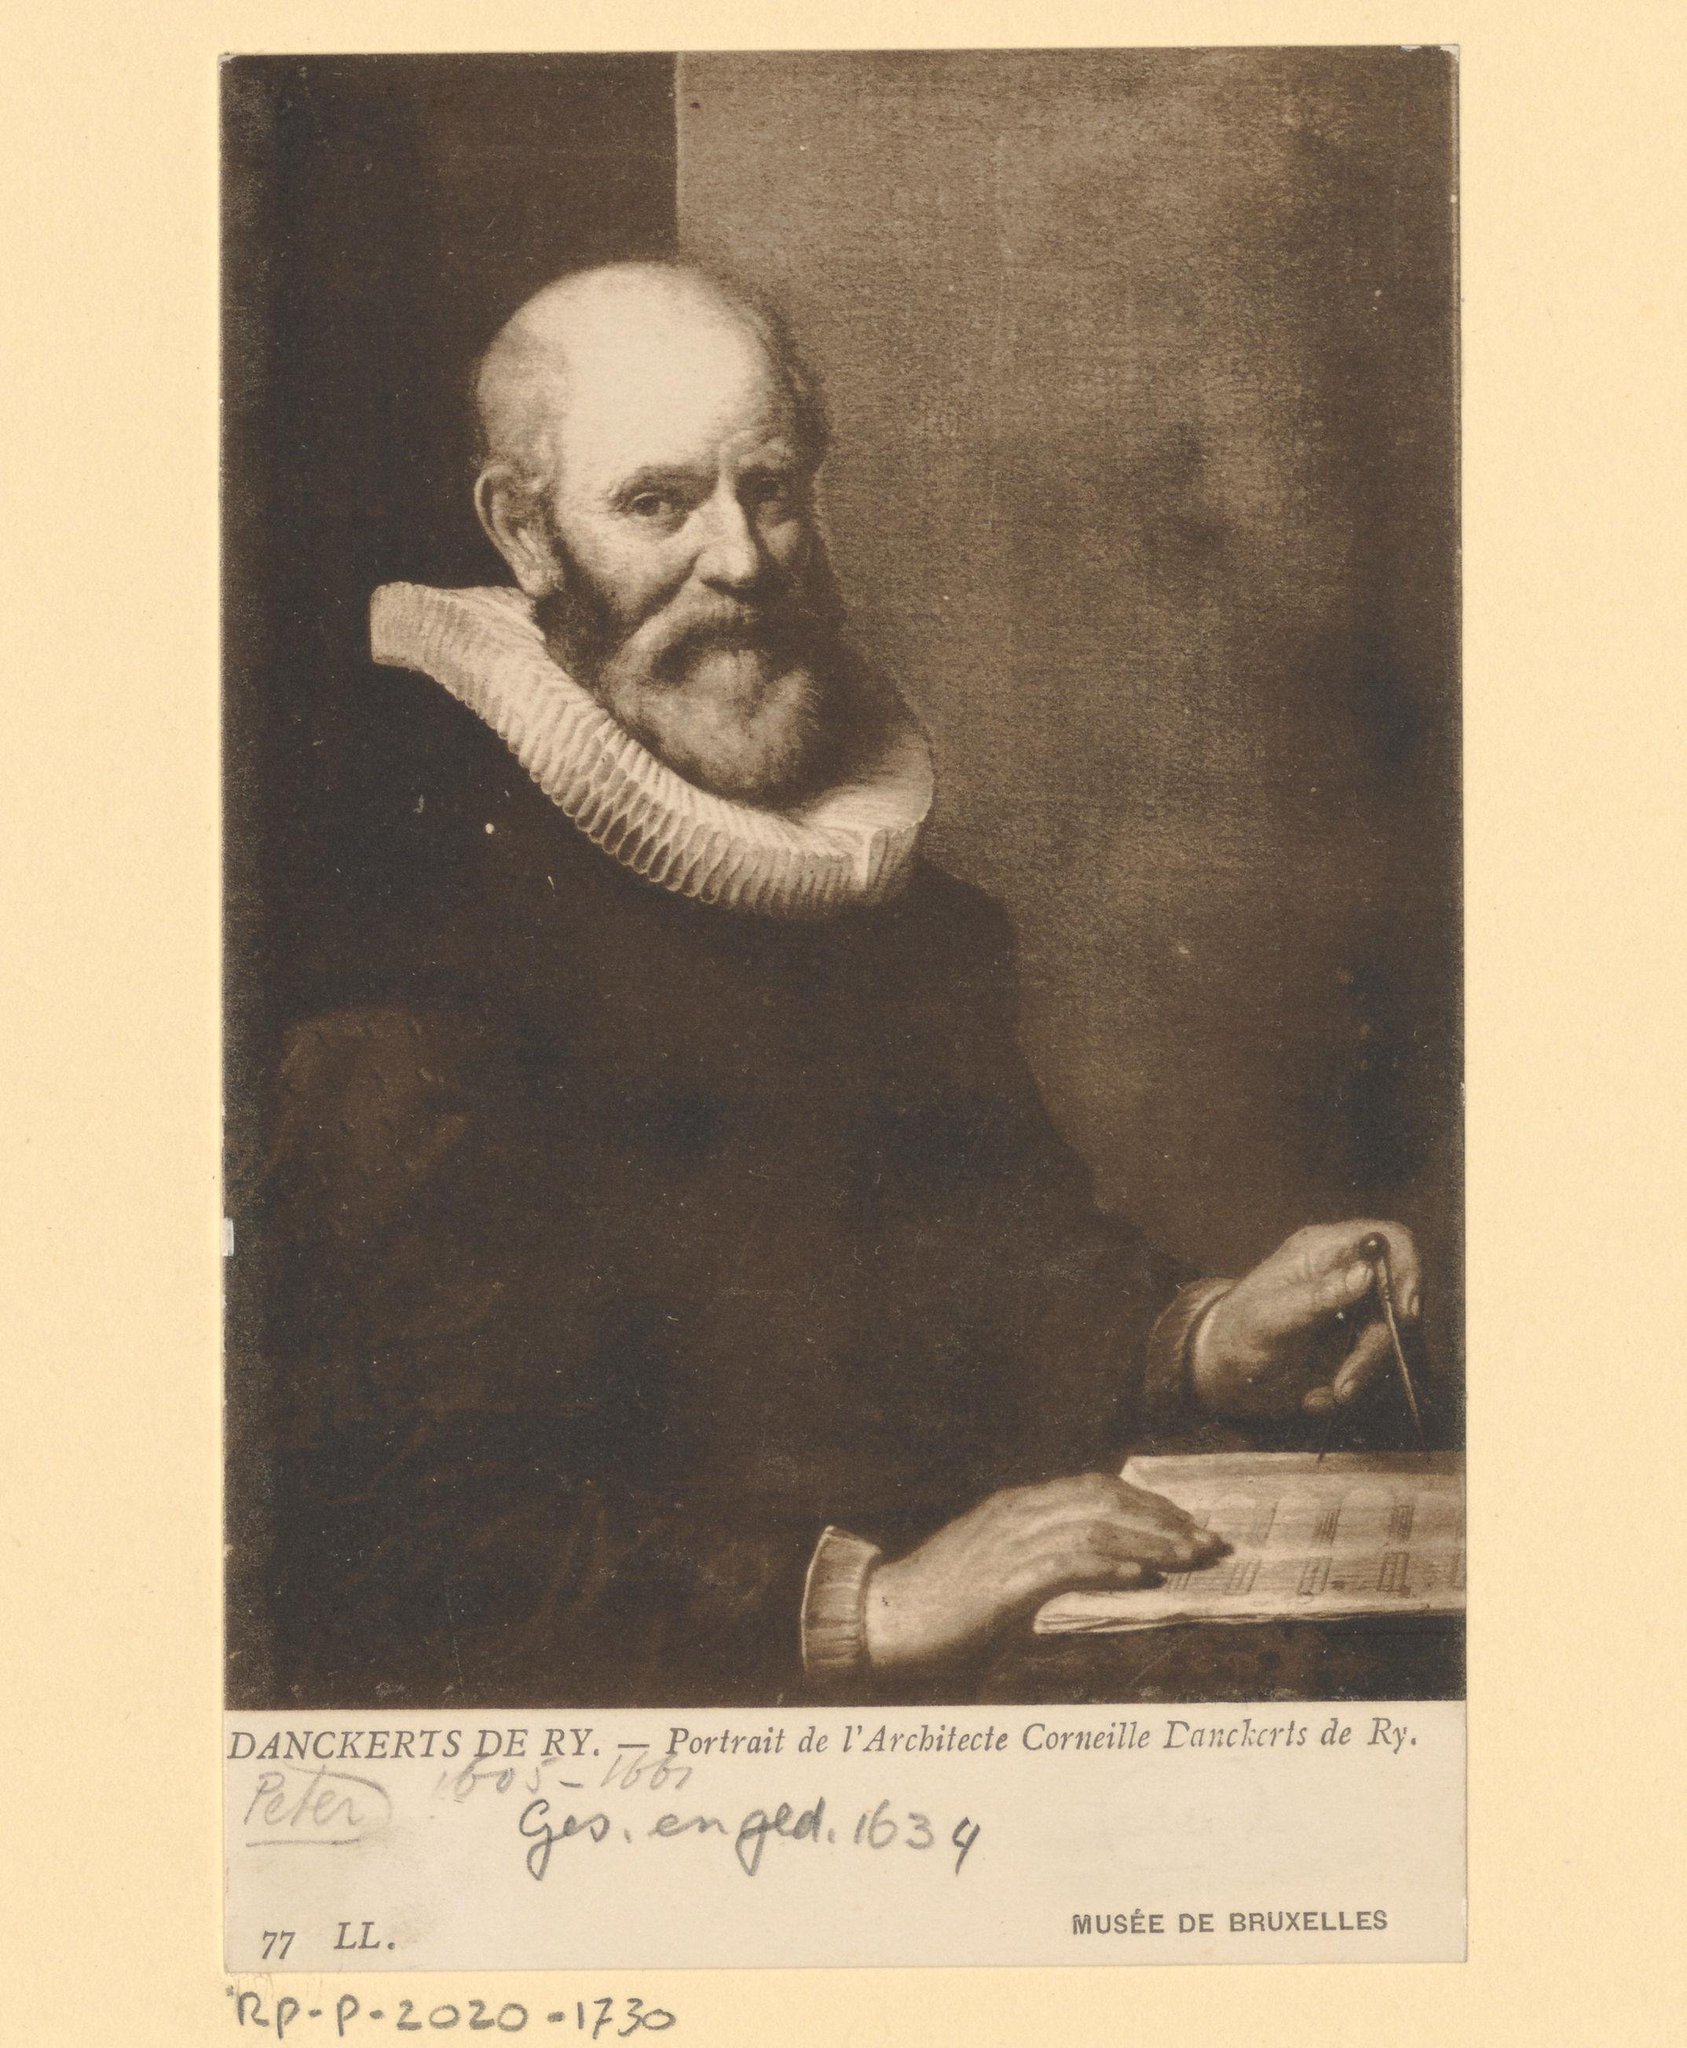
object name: ansichtkaart, prentbriefkaart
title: Portret van Cornelis Danckerts de Ry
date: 1905-1930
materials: cardboard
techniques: photograph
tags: historical persons, portrait, self-portrait of architect, compass